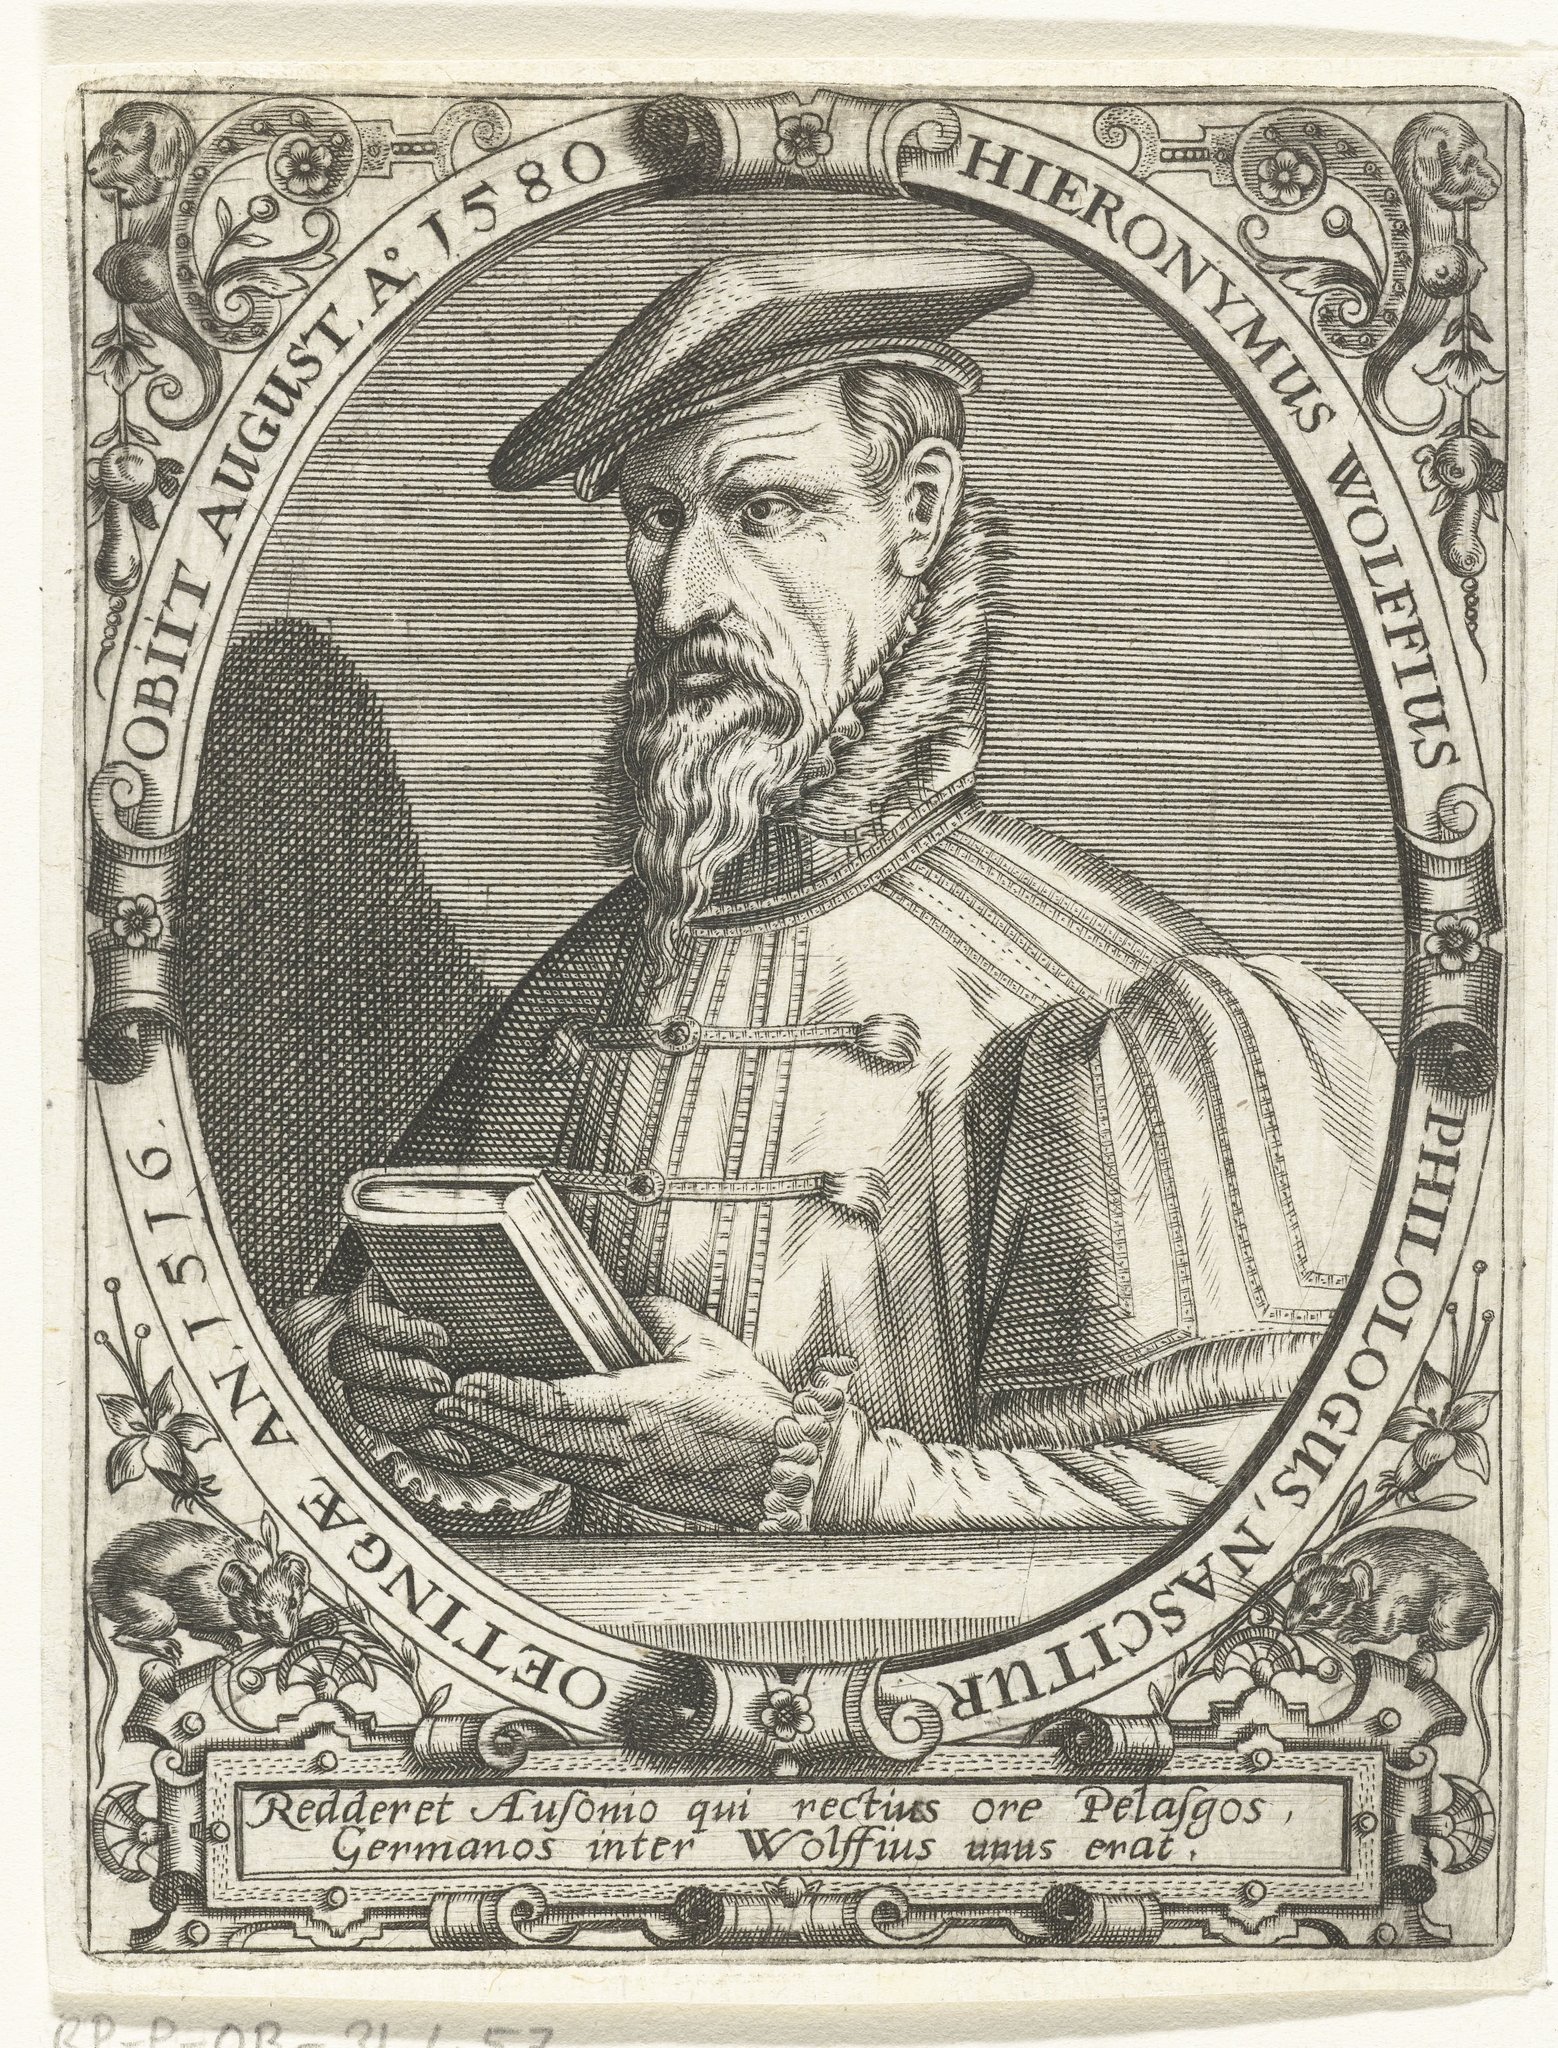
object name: book illustration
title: Hieronymus Wolffius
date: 1597-1599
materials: paper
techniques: engraving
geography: frankfurt am main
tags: bibliothecaris, humanist, hieronymus wolf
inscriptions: collector's mark: Lugt 2228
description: Gemaakt voor: J.J. Boissard, Icones virorum illustrium doctrina &c eruditione praestanti um contines. Frankfurt am Main: de Bry, 1597-1599.